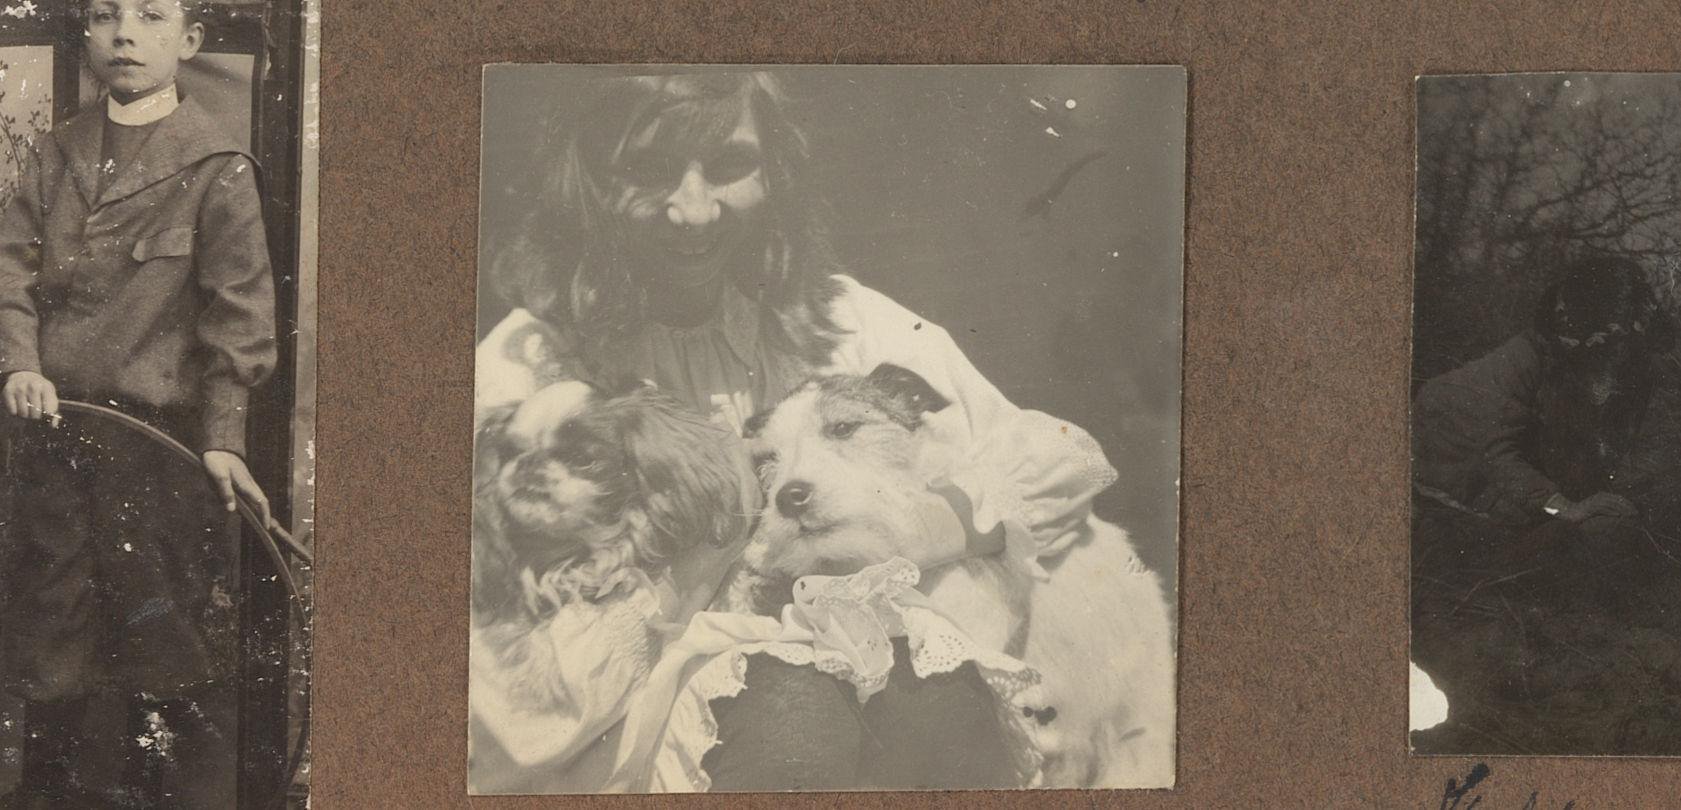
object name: photograph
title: Hilda met haar honden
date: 1880-1920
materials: photographic support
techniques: photography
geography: amsterdam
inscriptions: inscription: ‘Hilda met haar / honden’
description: Foto op bruin albumblad 26 van familiealbum van Alphons Diepenbrock.